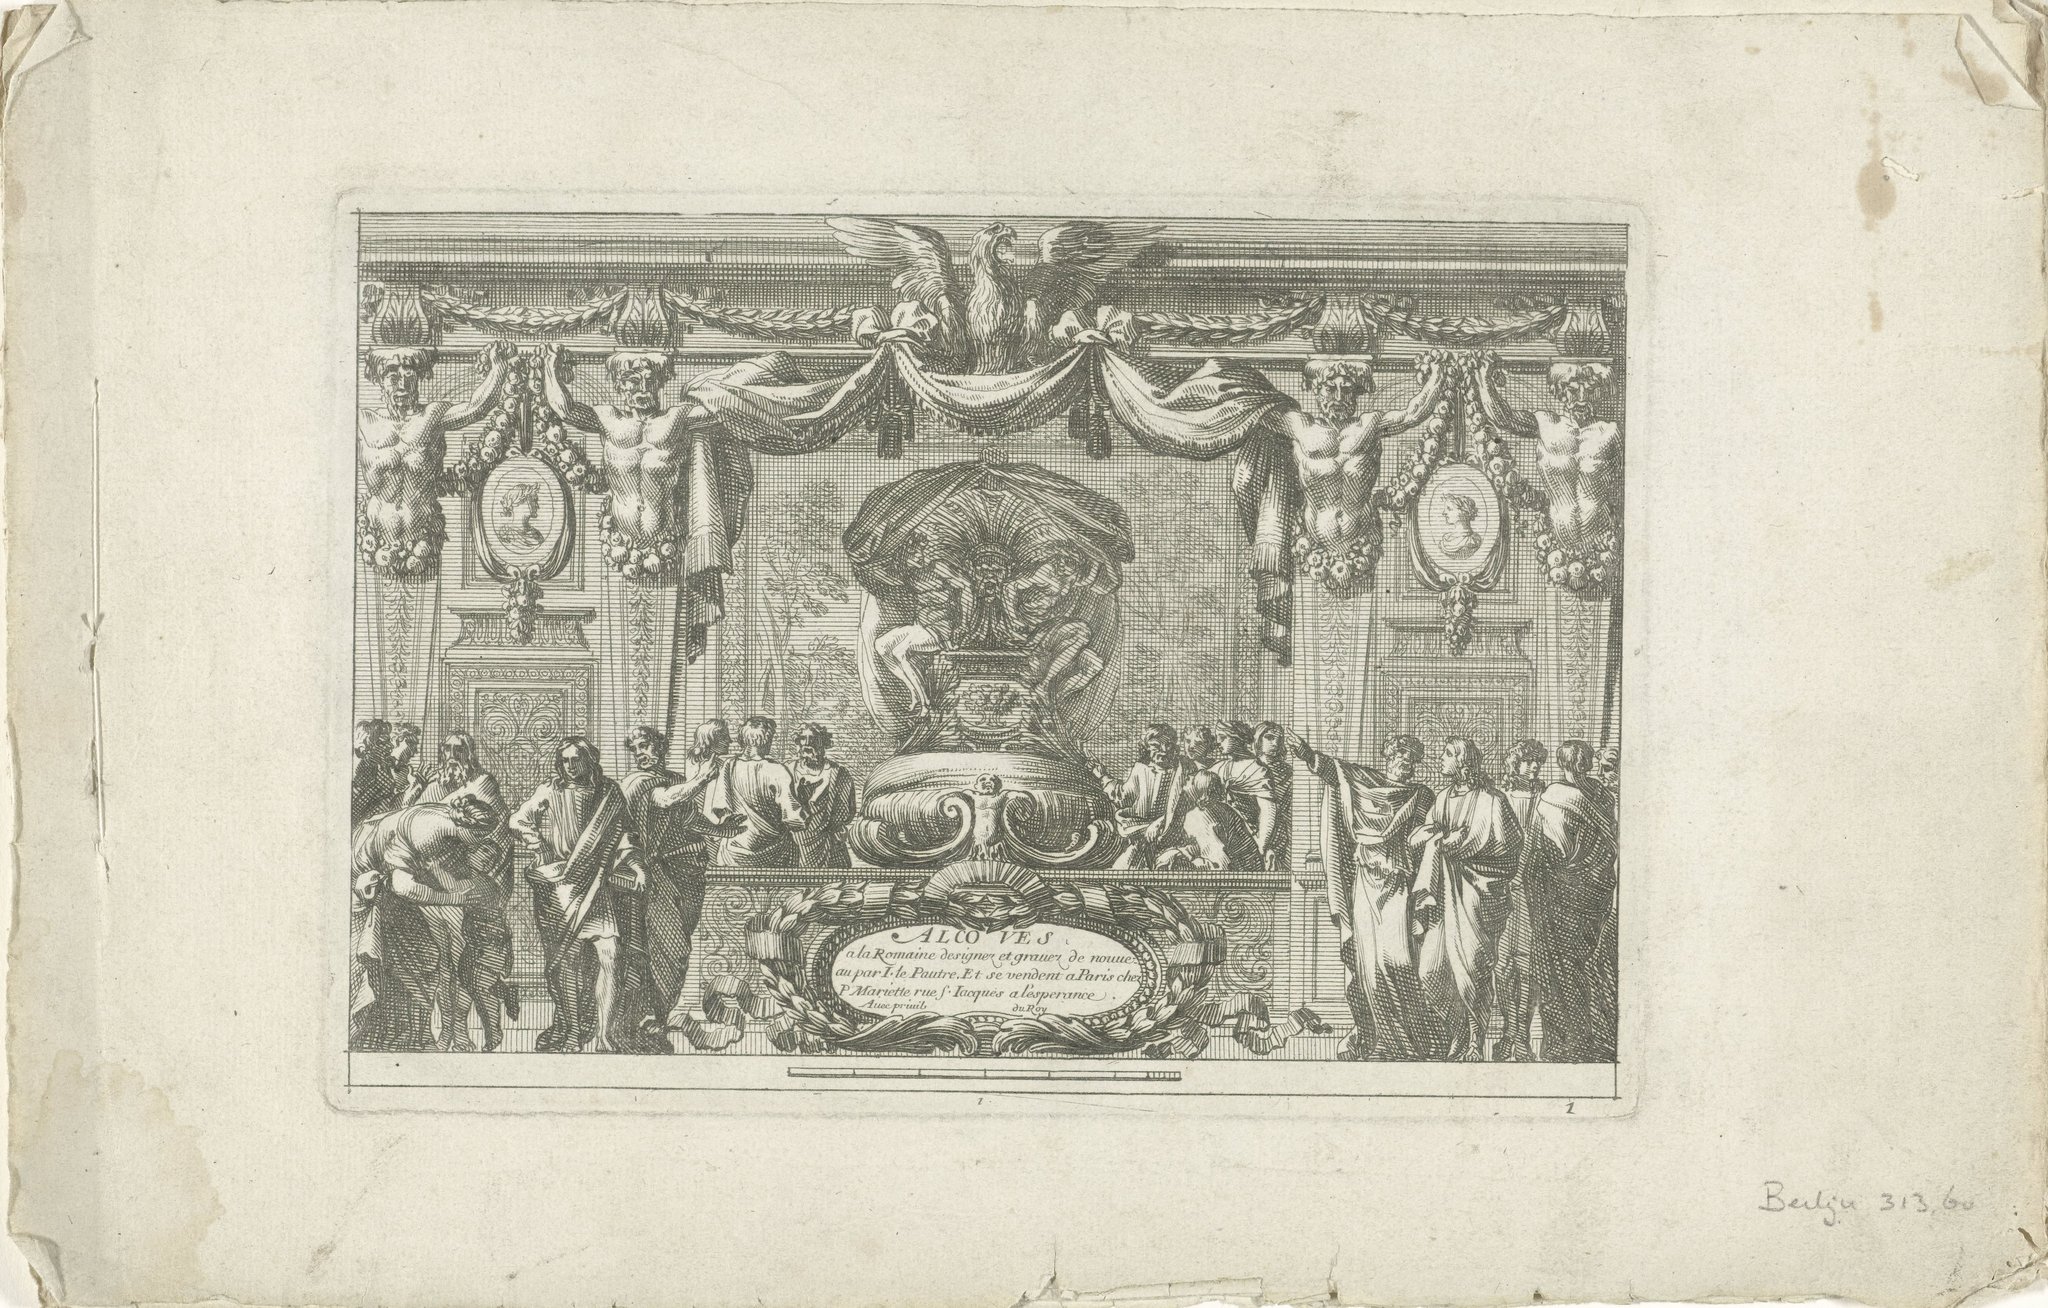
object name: titelblad, titelpagina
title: Titelblad: Alcoves a la Romaine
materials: paper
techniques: etching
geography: paris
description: Een alkoof met kariatiden, draperieën en aan de bovenzijde een adelaar. Middenonder een balustrade met cartouche met de serietitel. In de alkoof staan diverse figuren, wijzend naar het midden. Rechtsonder 1 genummerd.